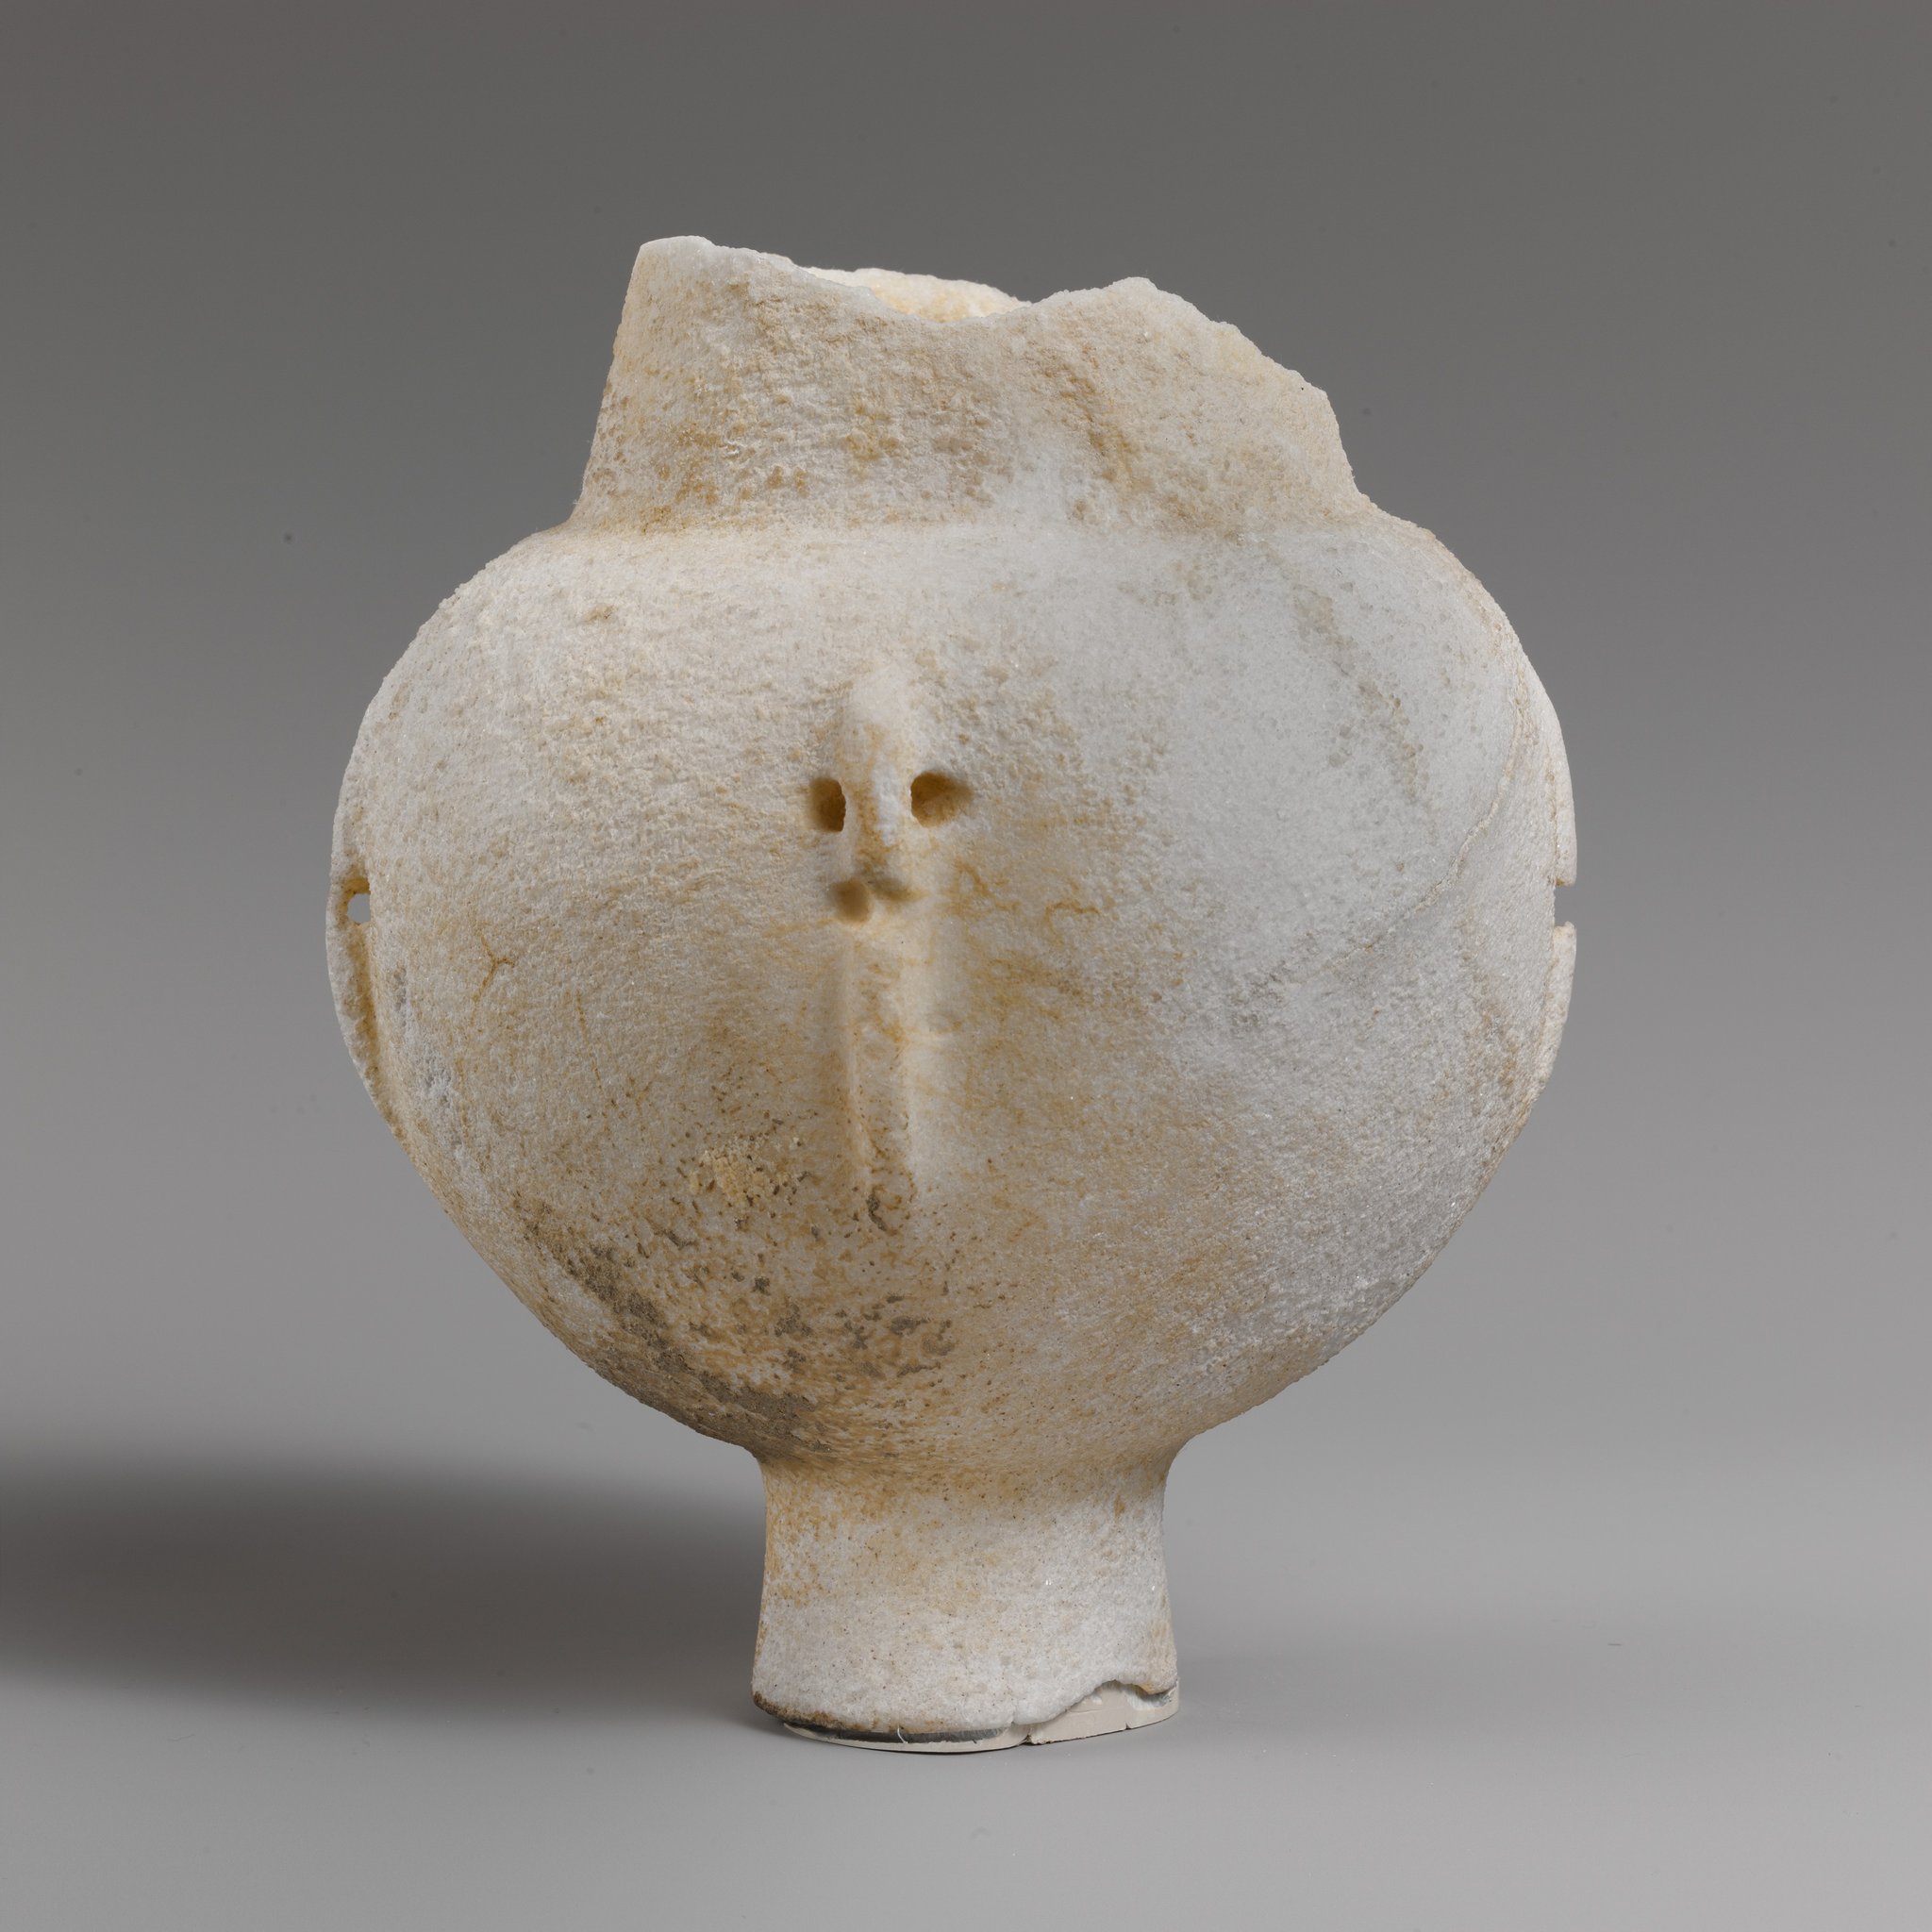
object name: kandila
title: Marble vase with high foot and four lug handles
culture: cycladic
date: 2800-2700 BCE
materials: marble